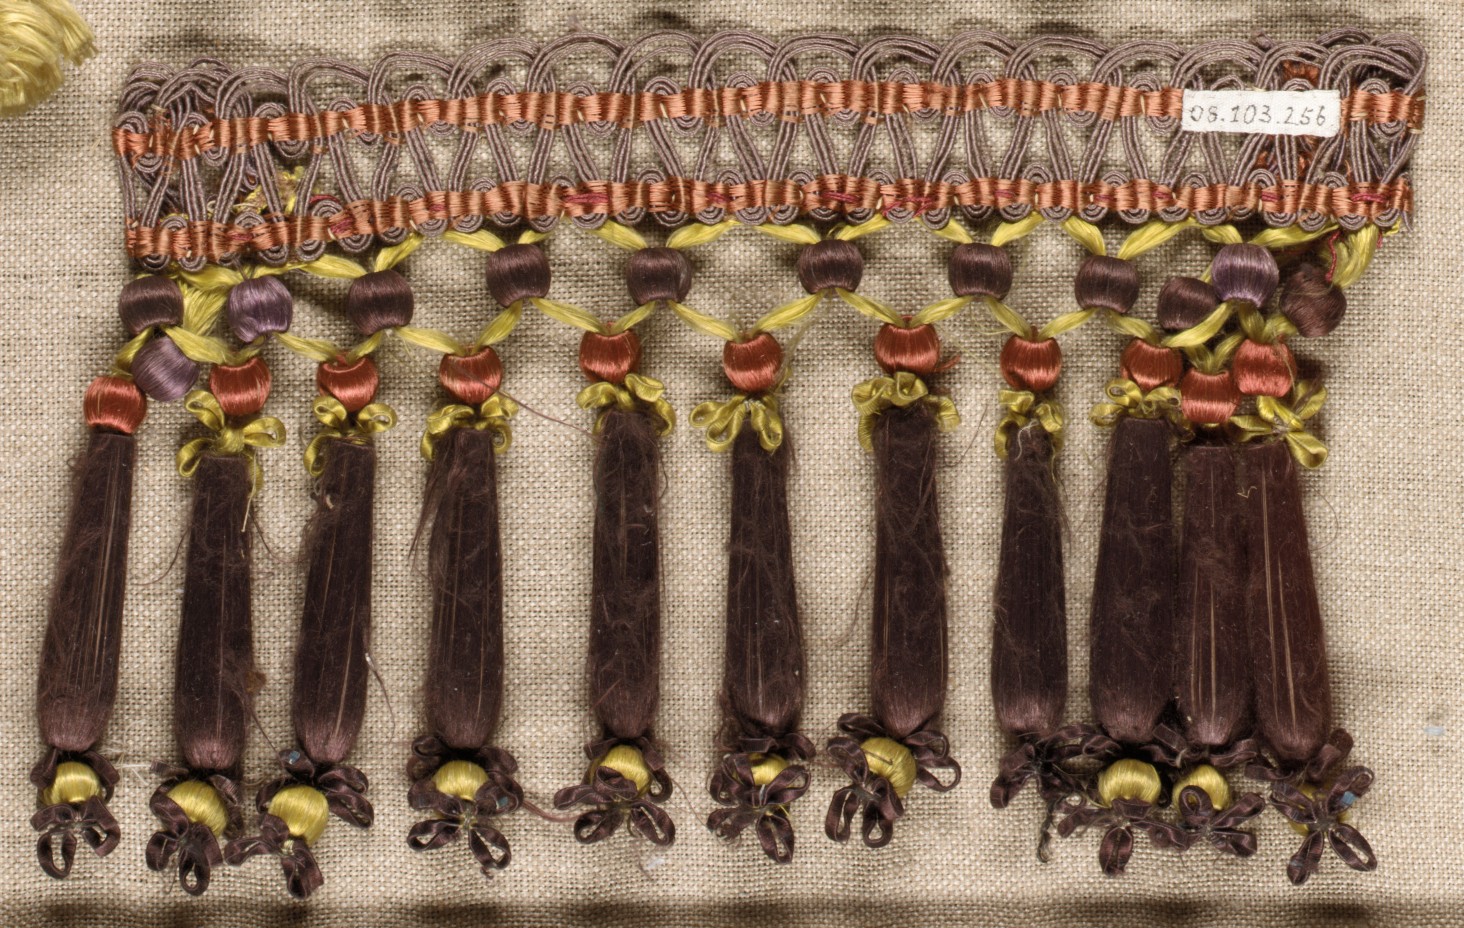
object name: fringe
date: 1801-1900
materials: silk